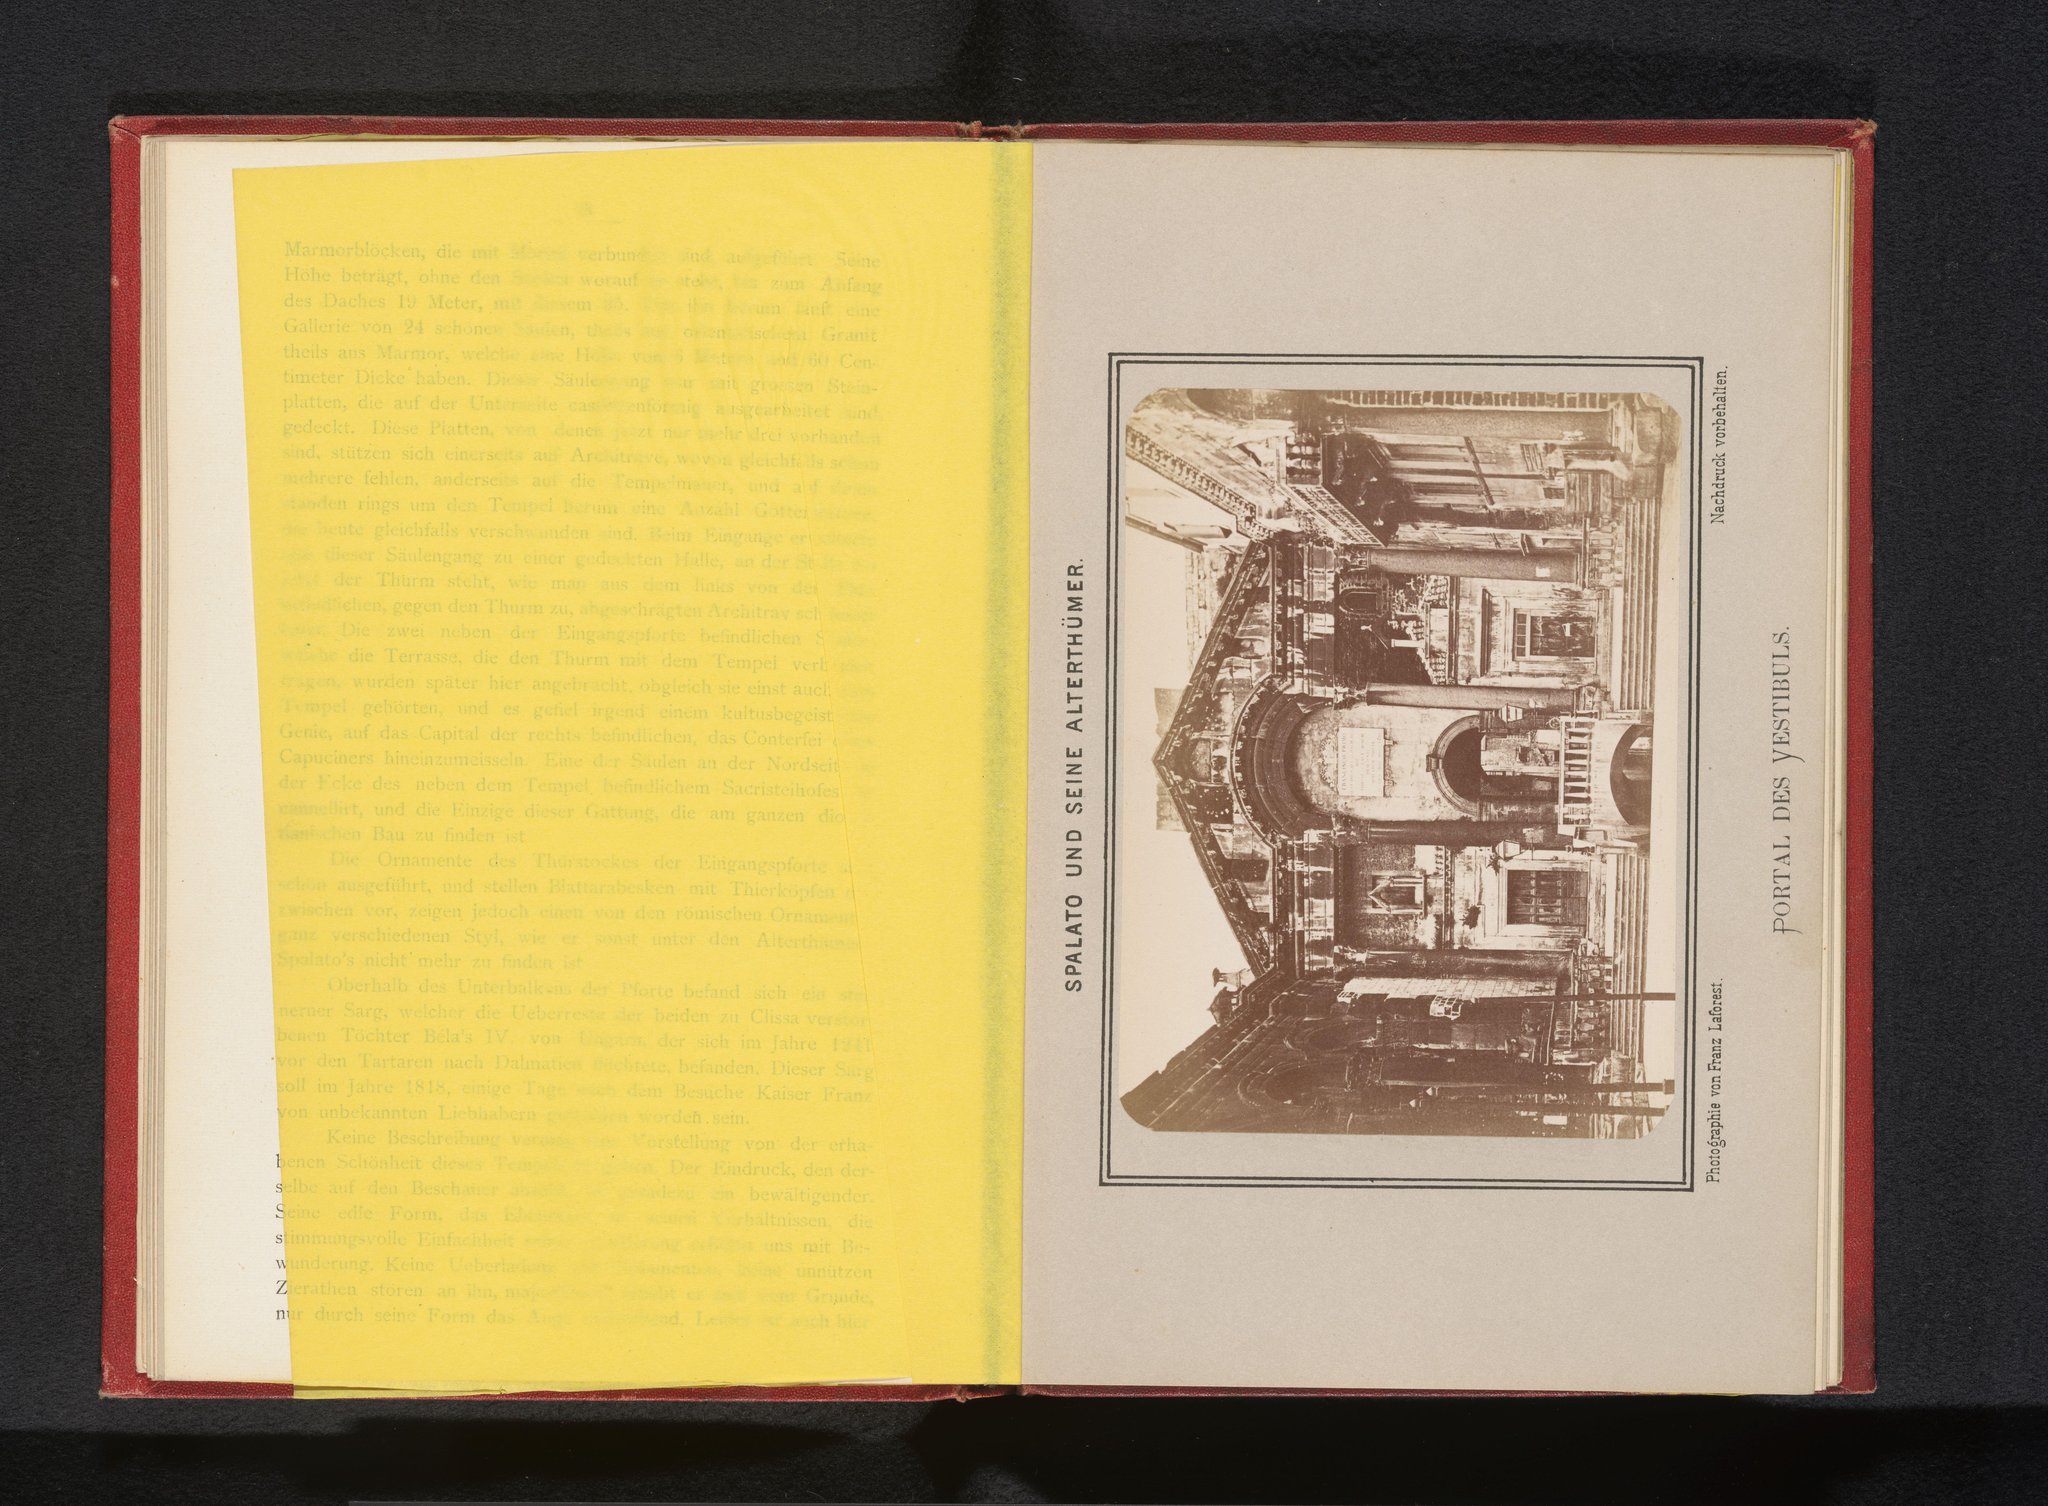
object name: page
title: Portal des vestibuls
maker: franz thiard de laforest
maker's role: fotograaf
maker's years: 1838-1911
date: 1868-1878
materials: photographic support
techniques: albumen print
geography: split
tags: palace, vestibule, hall, façade (of house or building)